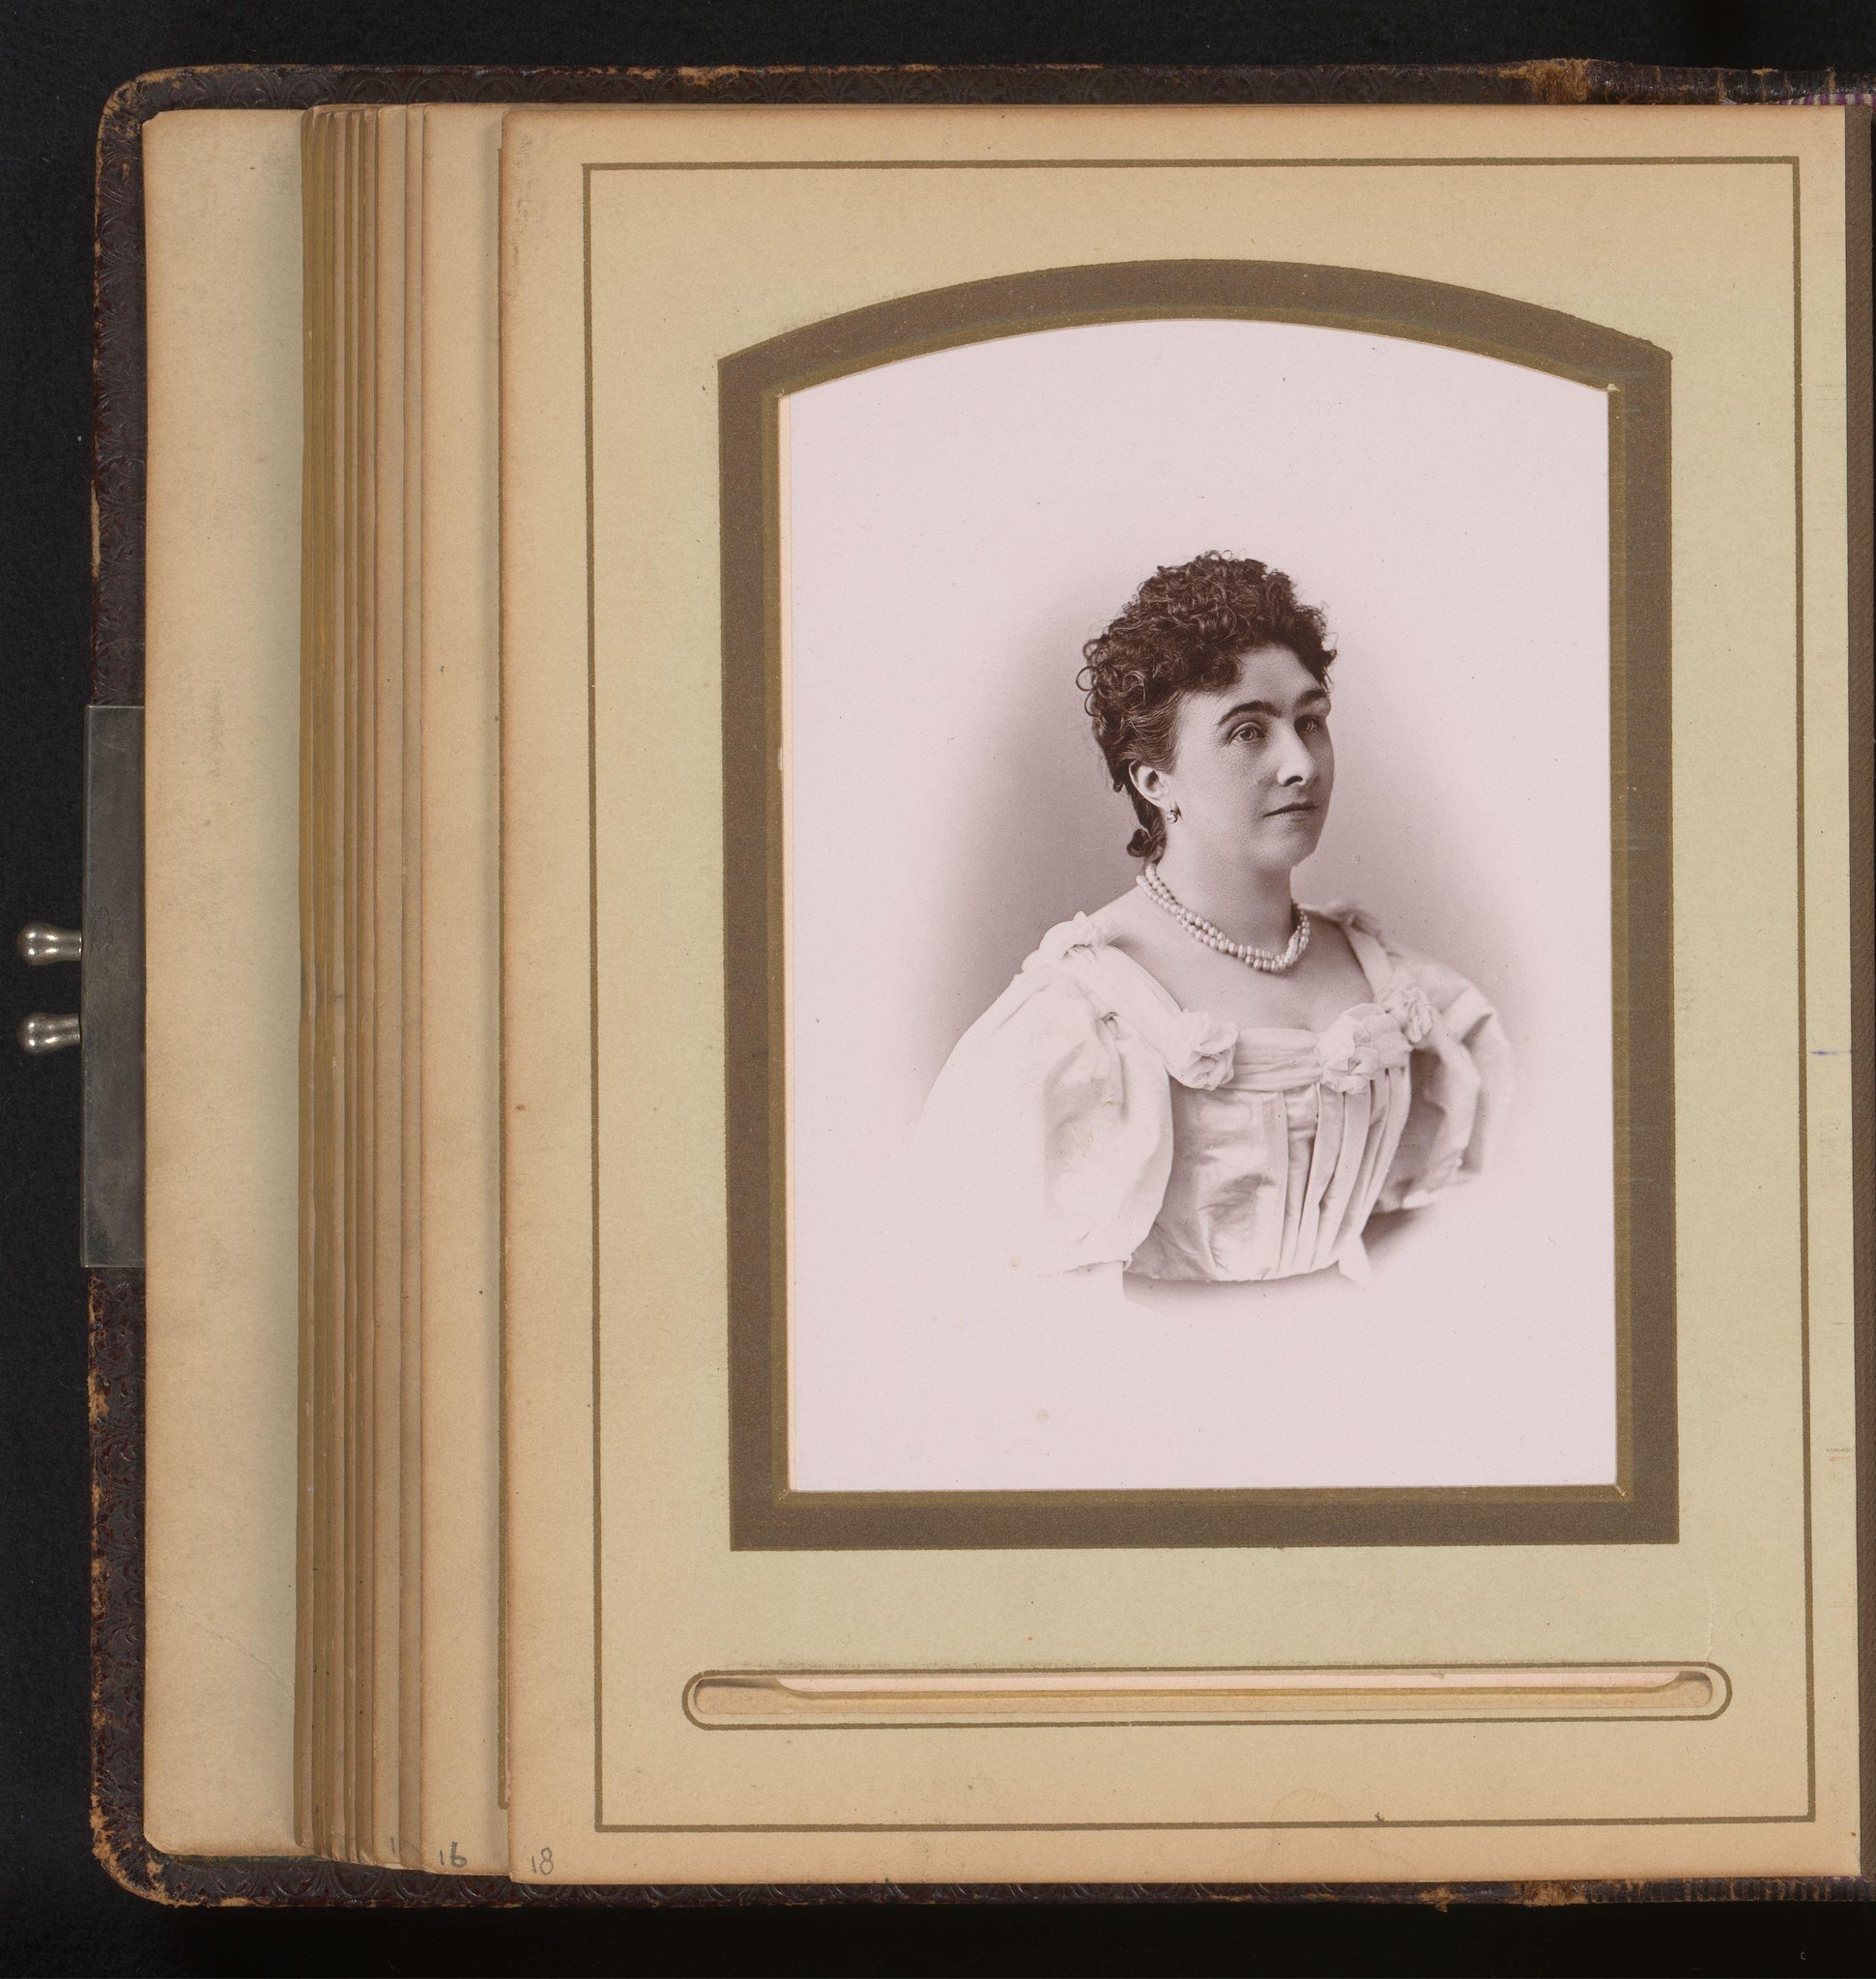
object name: photograph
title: Portret van een vrouw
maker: alphonse-justin liébert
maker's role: fotograaf, marinier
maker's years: 1827-1914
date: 1880-1913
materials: cardboard, photographic support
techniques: collodion silver print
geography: paris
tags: historical persons - bb - woman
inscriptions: inscription: ‘PHOTOGRAPHIE/ Américaine/ A. Liébert/ Paris/ 6, Rue de Londres, 6./ Photographie Inaltérable/ AU CHARBON + AU PLATINE/ & à la Pyroxyline Argentique/ HOTEL PRIVÉ/ Photographie/ a la Lumière Électrique/ PROCÉDÉ BREVETÉ S.G.D.G’